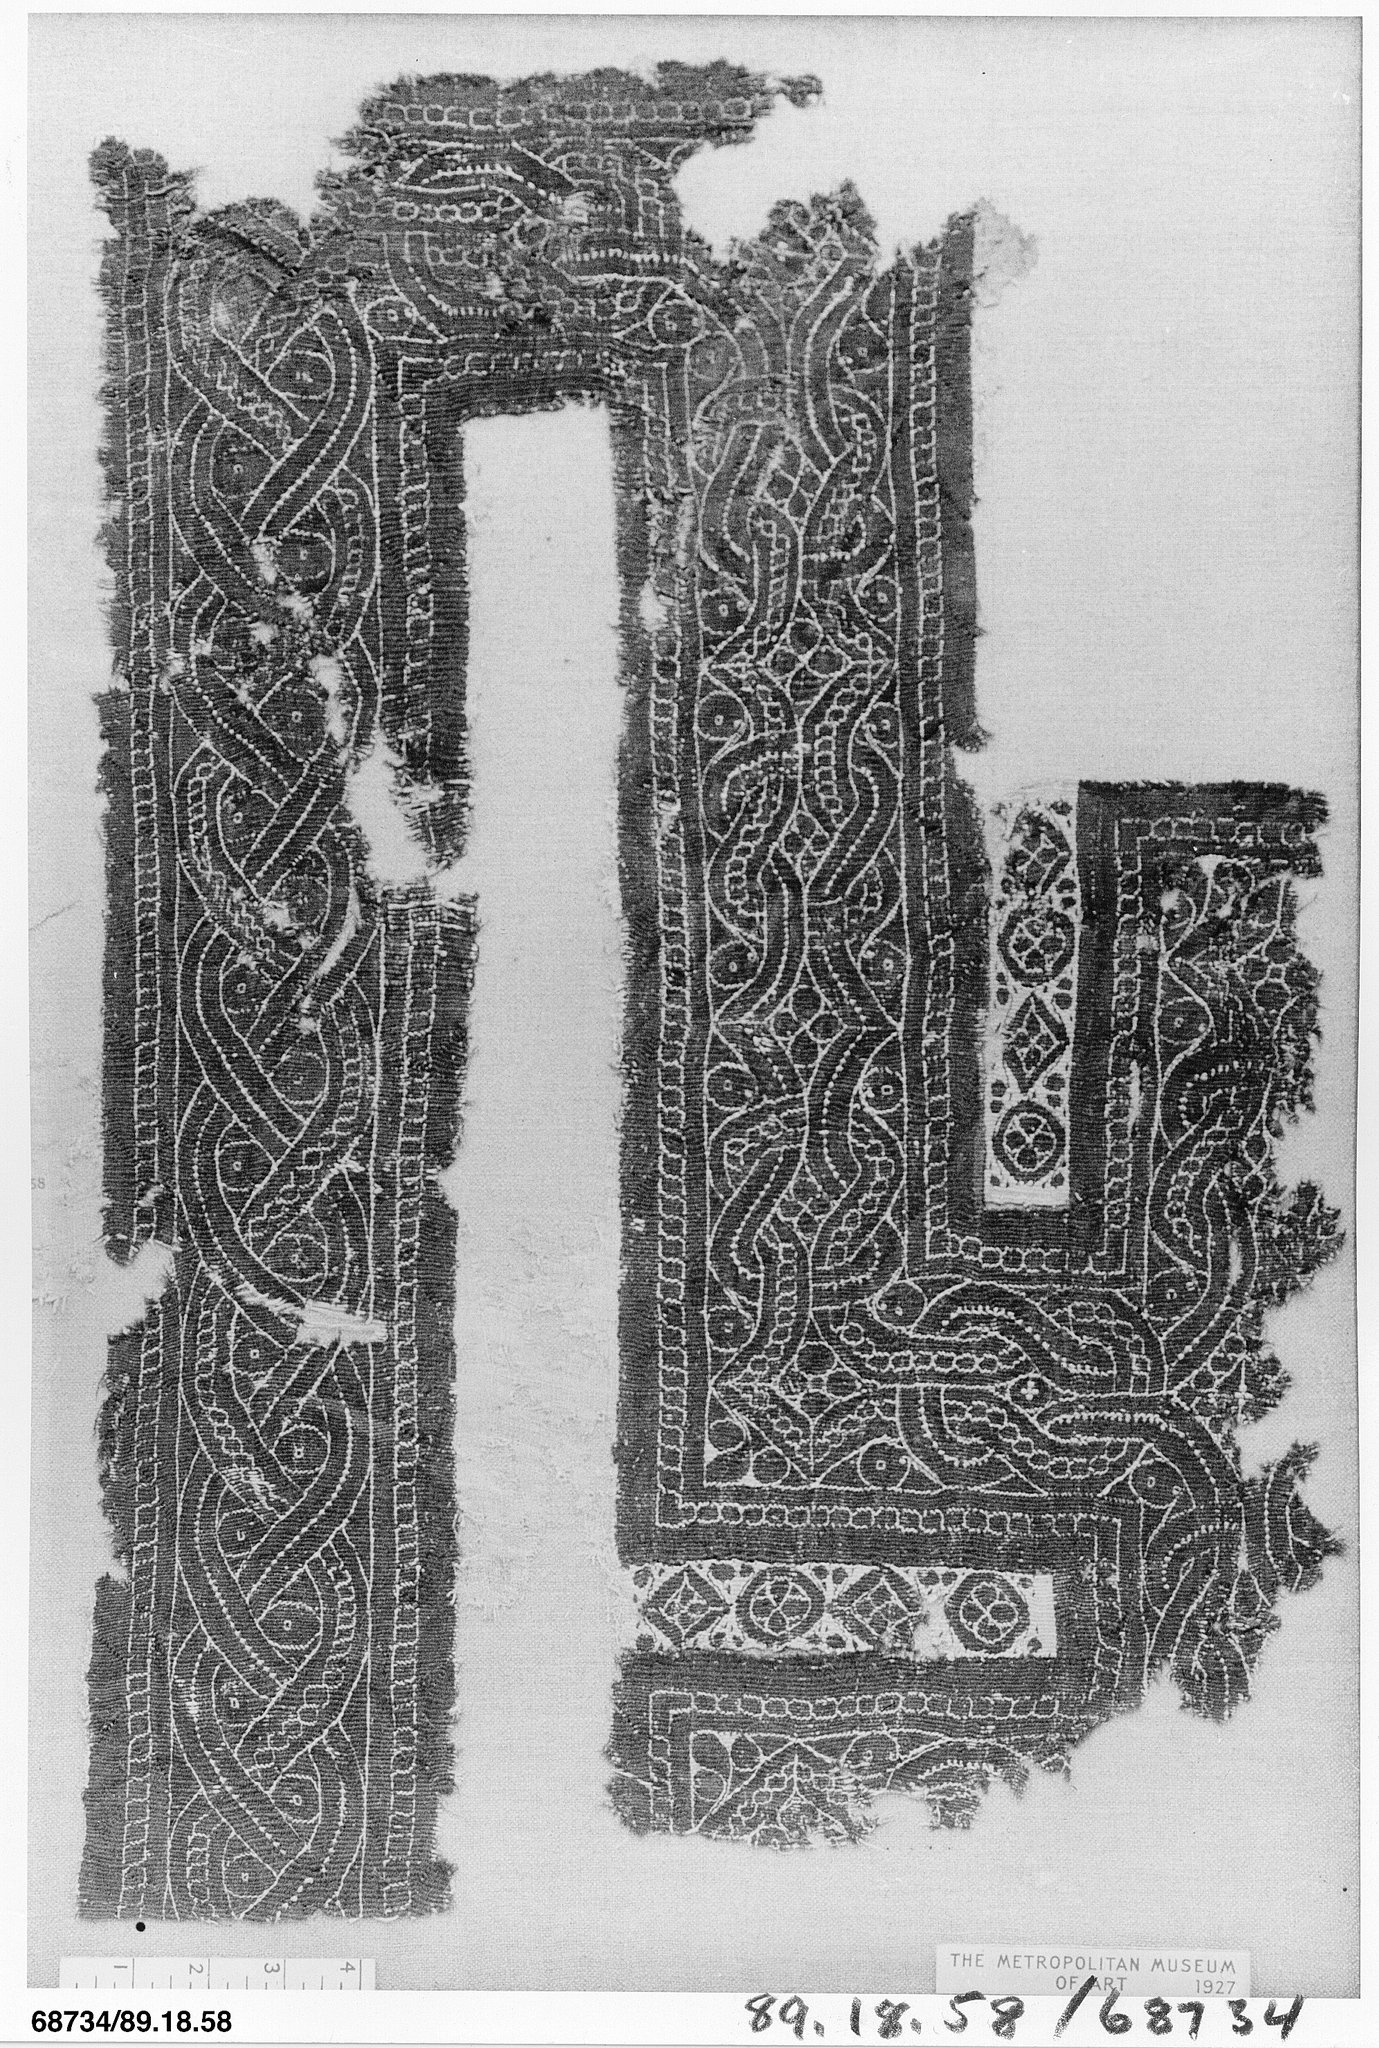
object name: textile fragment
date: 201-400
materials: linen, wool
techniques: weave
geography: egypt